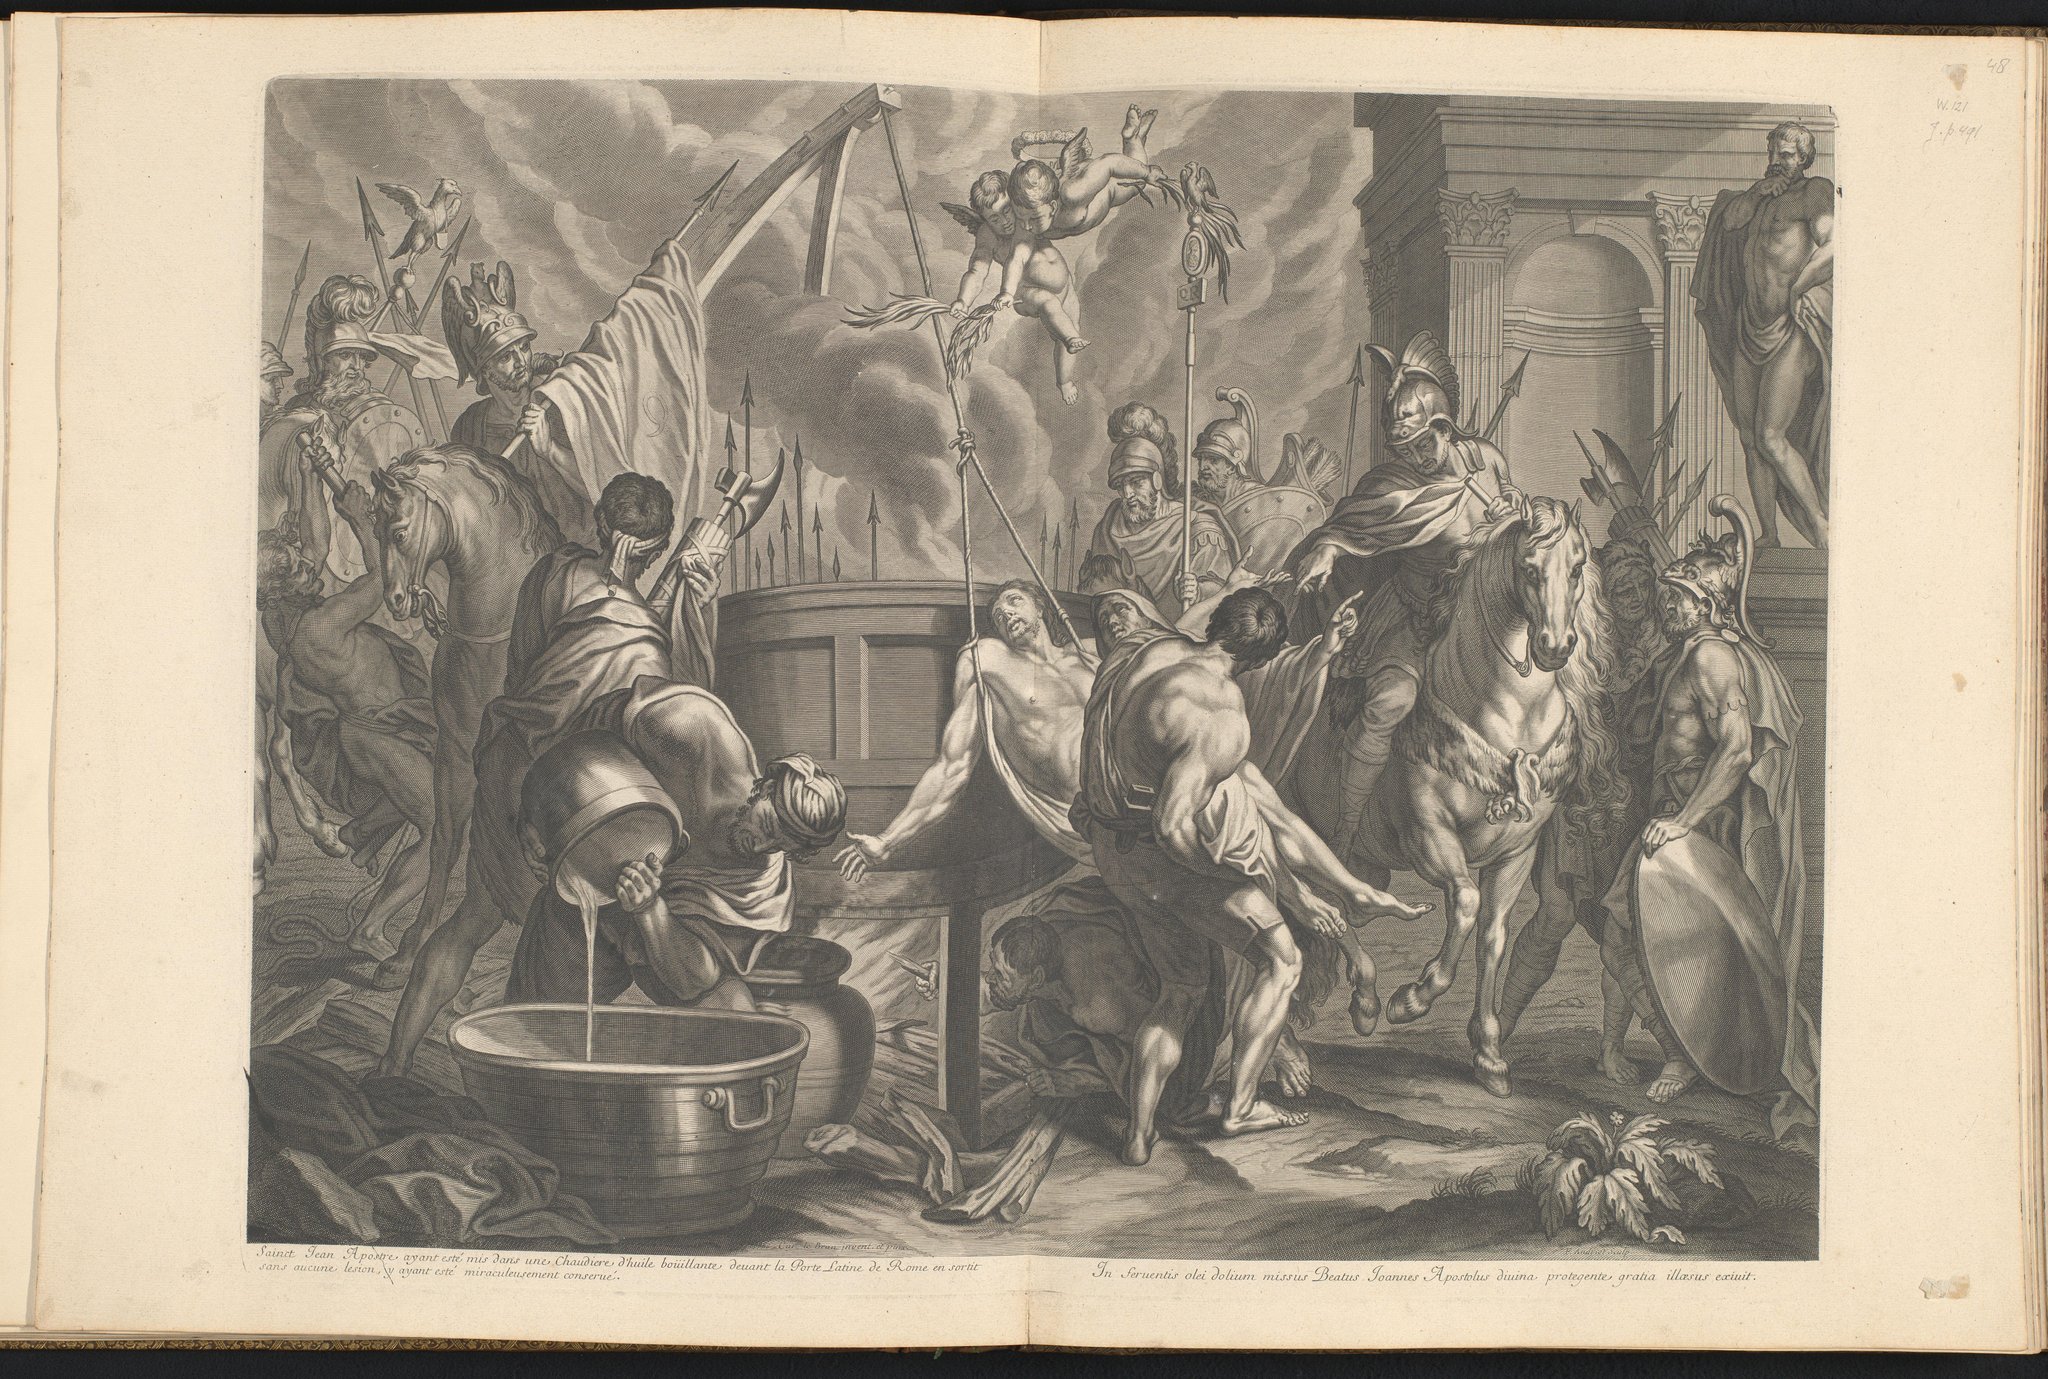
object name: print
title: Saint Jean Apostre ayant esté mis dans une Chaudiere d'huile boüillante (...)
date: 1665-1704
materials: paper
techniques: engraving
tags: the apostle john the evangelist; possible attributes: book, cauldron, chalice with snake, eagle, palm, scroll - martyrdom, suffering, misfortune, death of male saint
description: Deze prent maakt deel uit van een album.